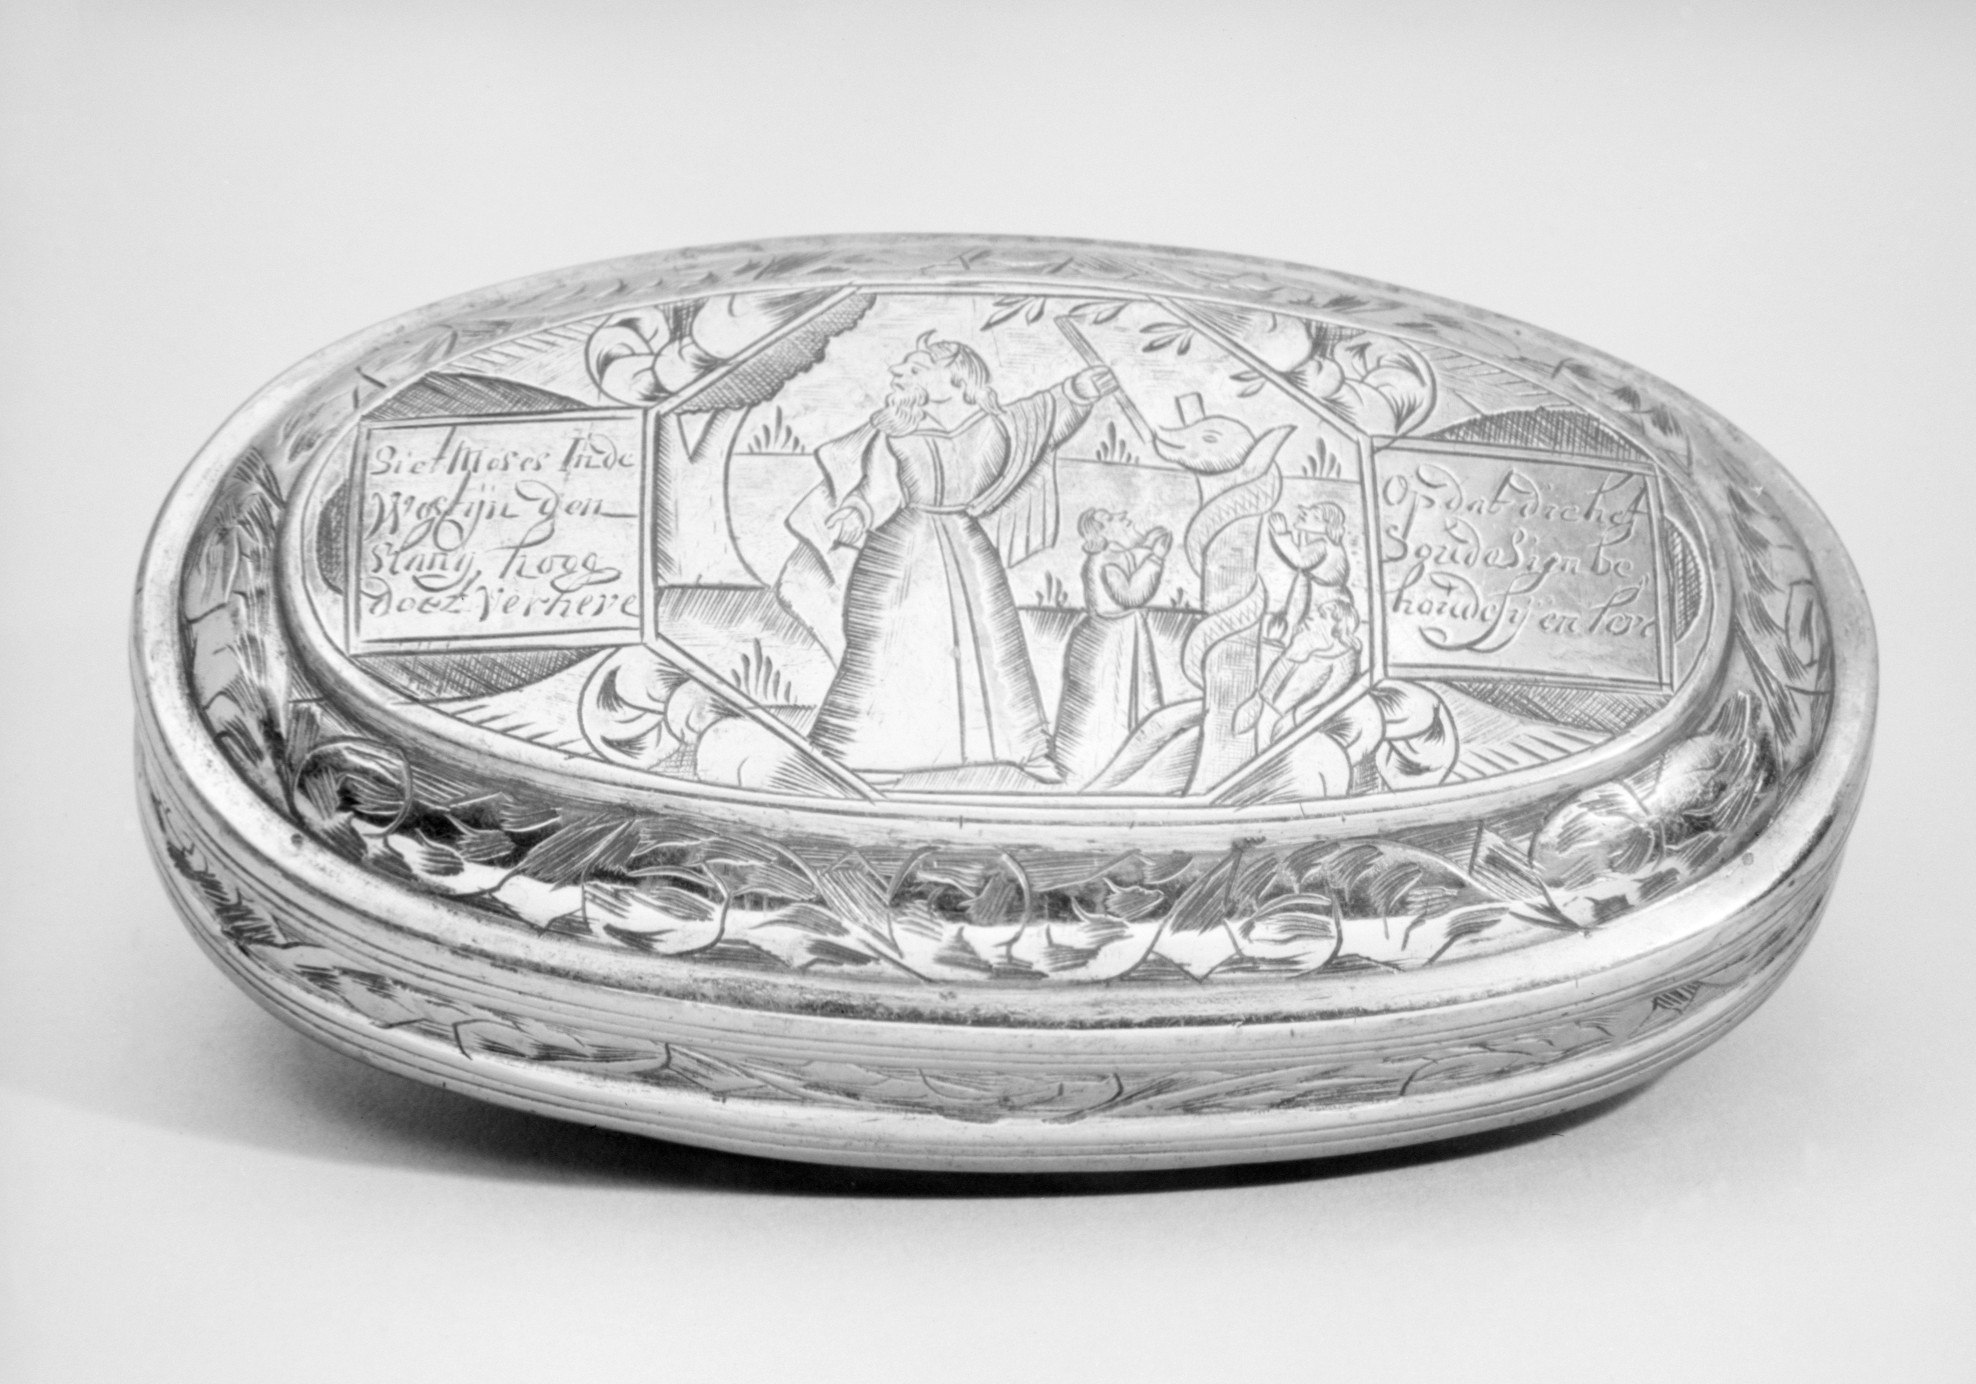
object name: tobacco box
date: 1701-1800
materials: brass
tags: men,serpents,moses